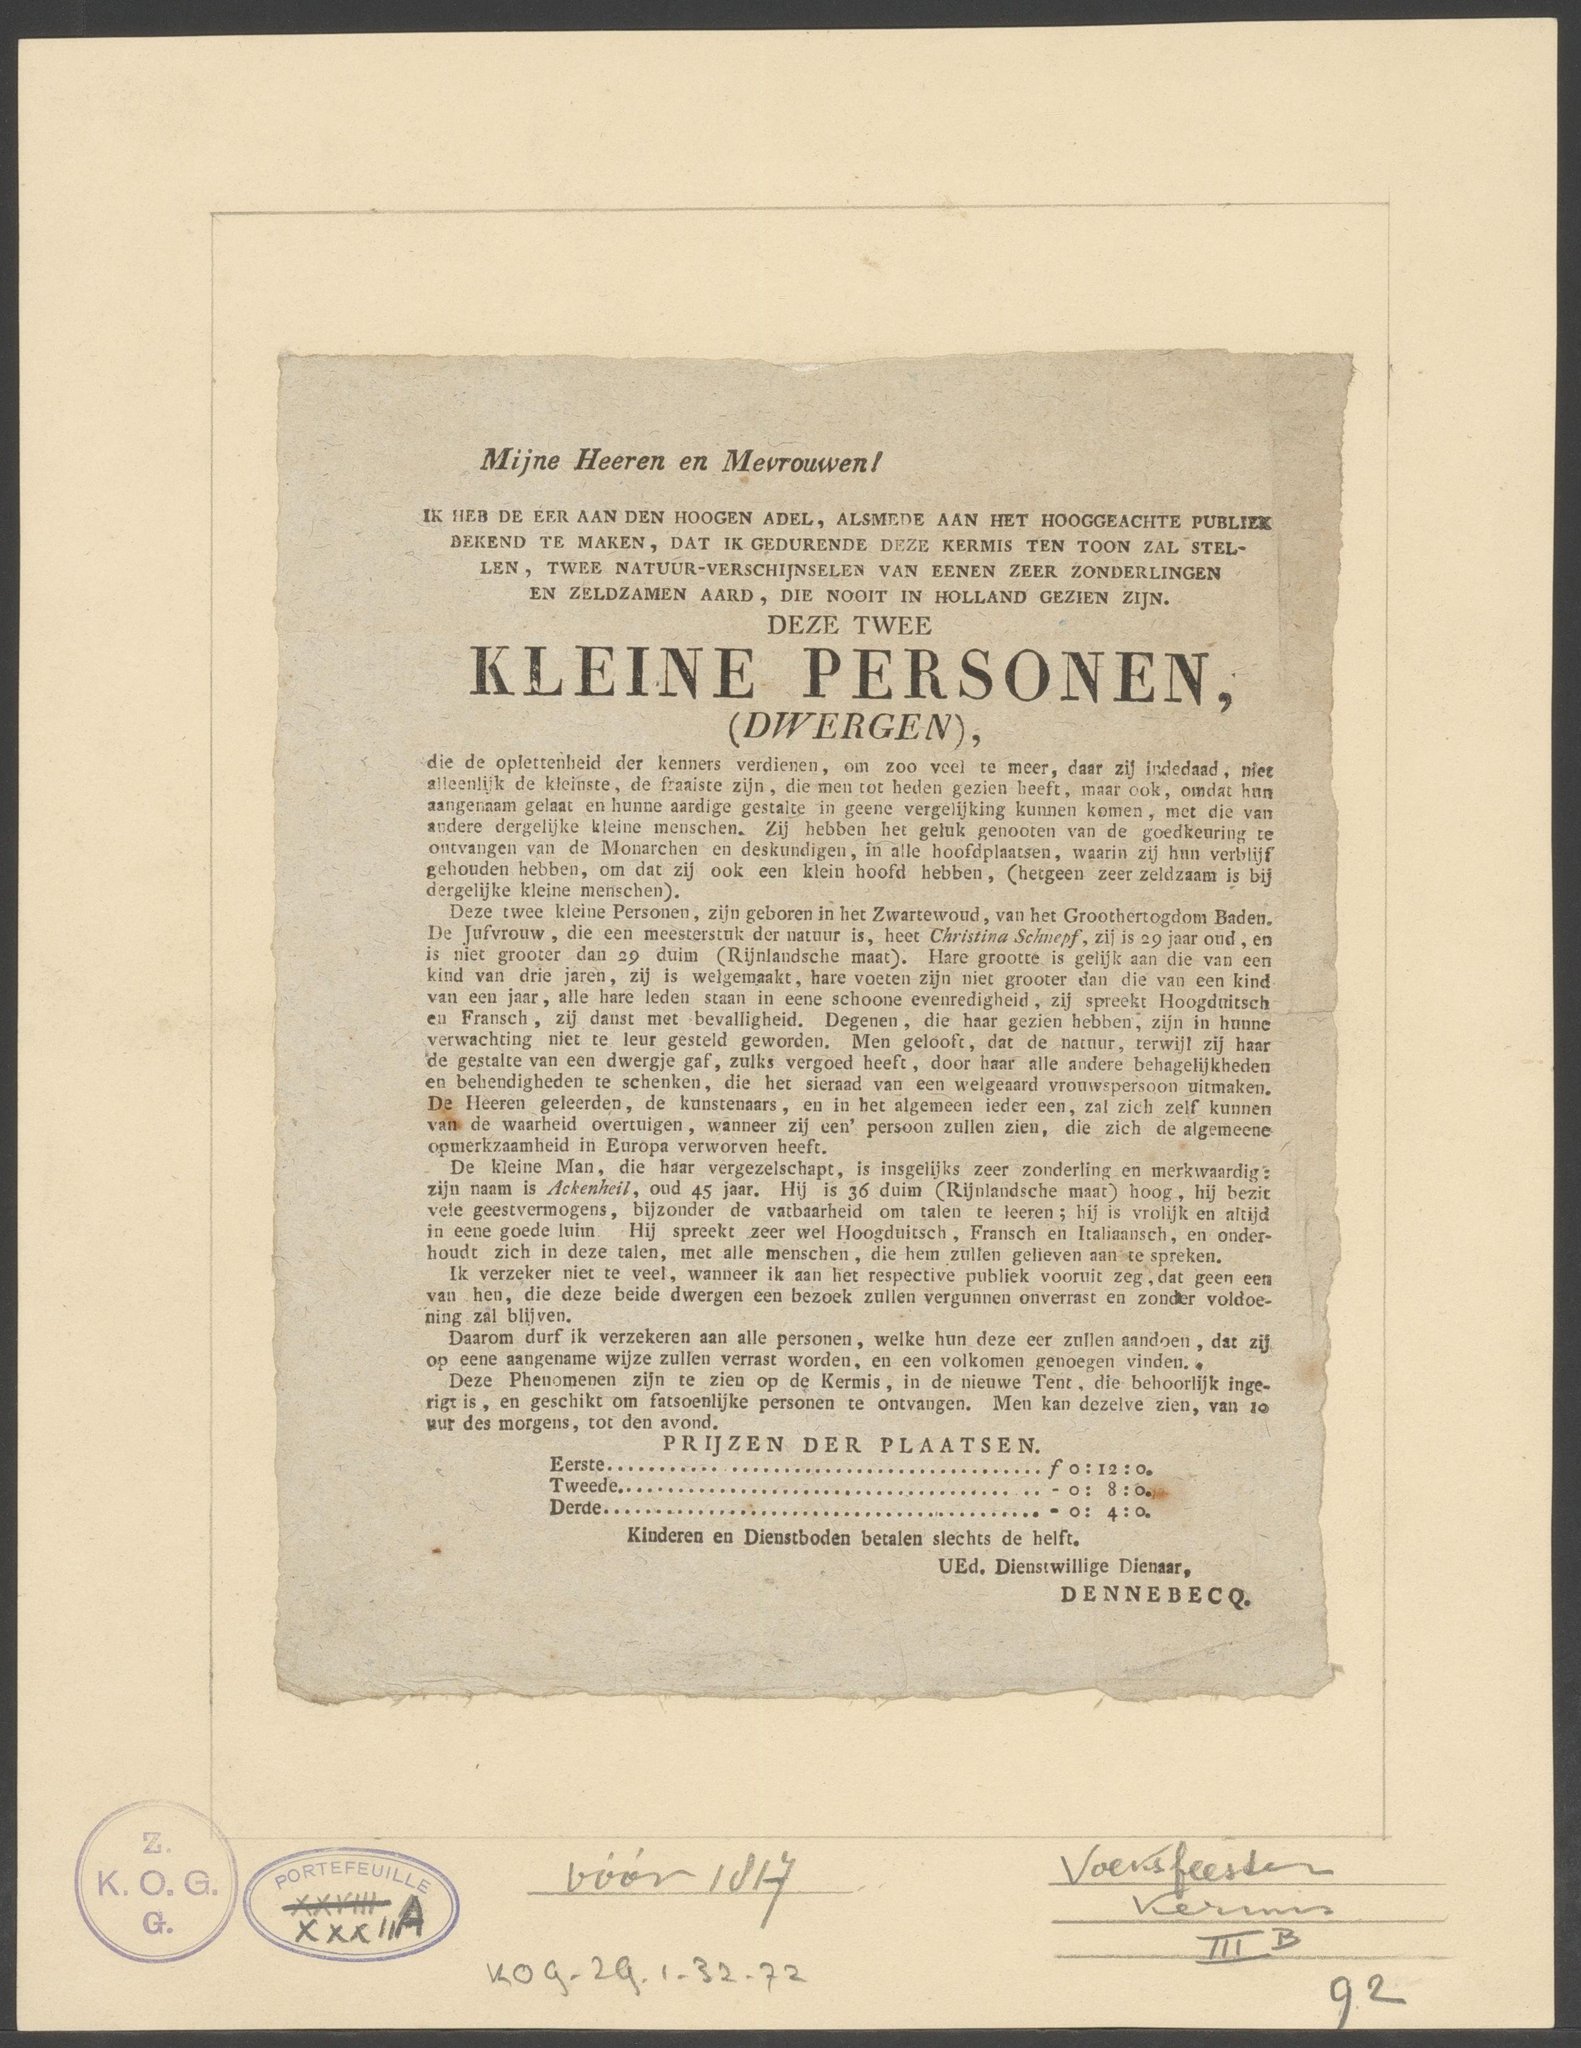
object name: reclamebiljet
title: Strooibiljet met reclame voor bezichtiging van twee kleine mensen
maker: Anonymous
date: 1806-1815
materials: paper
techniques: letterpress printing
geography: netherlands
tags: little people, pleasure fair and circus, human monstrosities ~ freak show, amsterdam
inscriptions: collector's mark: Lugt 1641, collector's mark